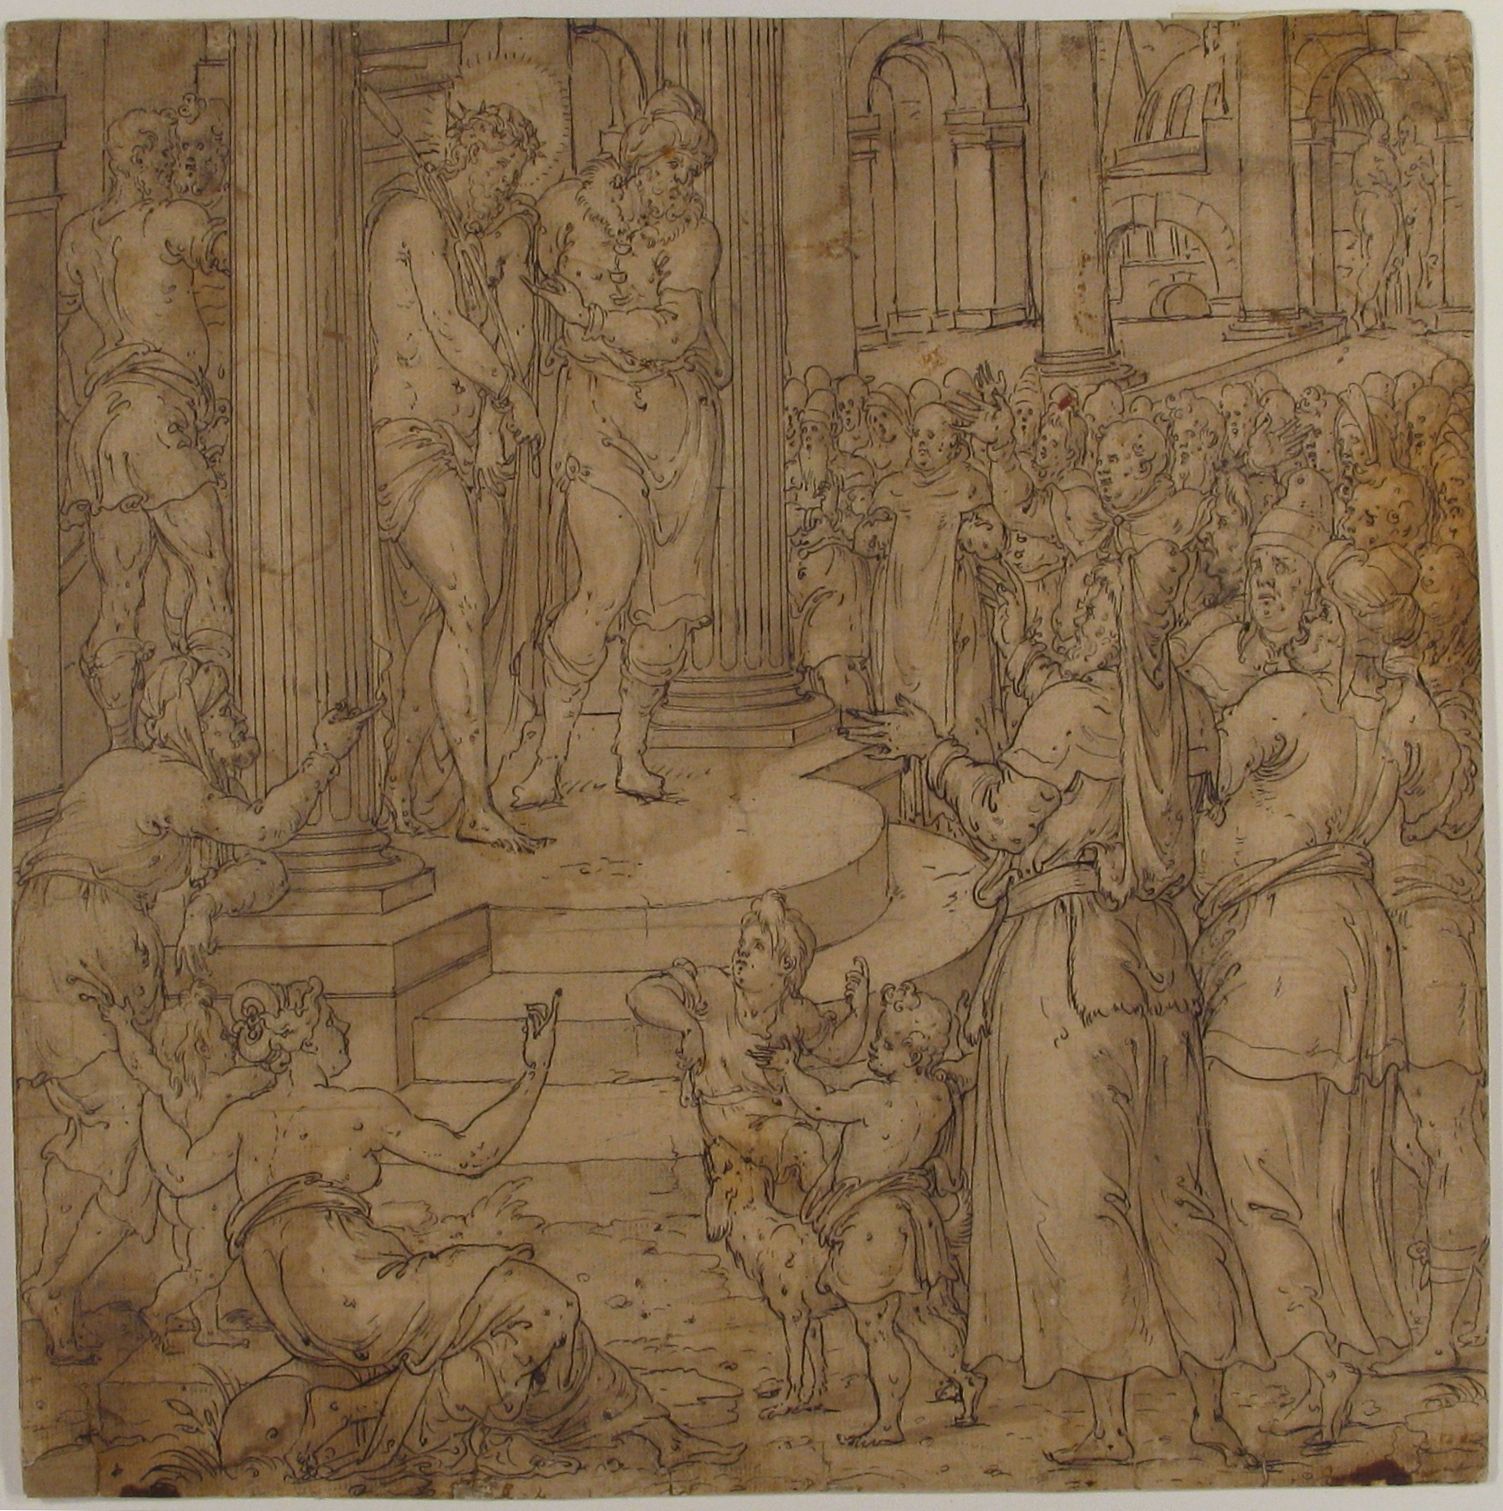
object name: drawing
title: Ecce Homo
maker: anonymous, french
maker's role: artist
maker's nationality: french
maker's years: 1400-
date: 1500-1599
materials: ink, paper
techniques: brush, pen, wash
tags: christ,crowd